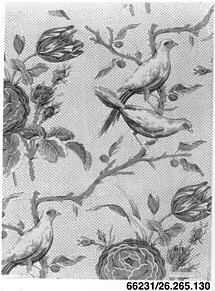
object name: floral print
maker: gorgerât et cie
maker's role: manufactory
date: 1787-1789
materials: linen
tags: birds,flowers